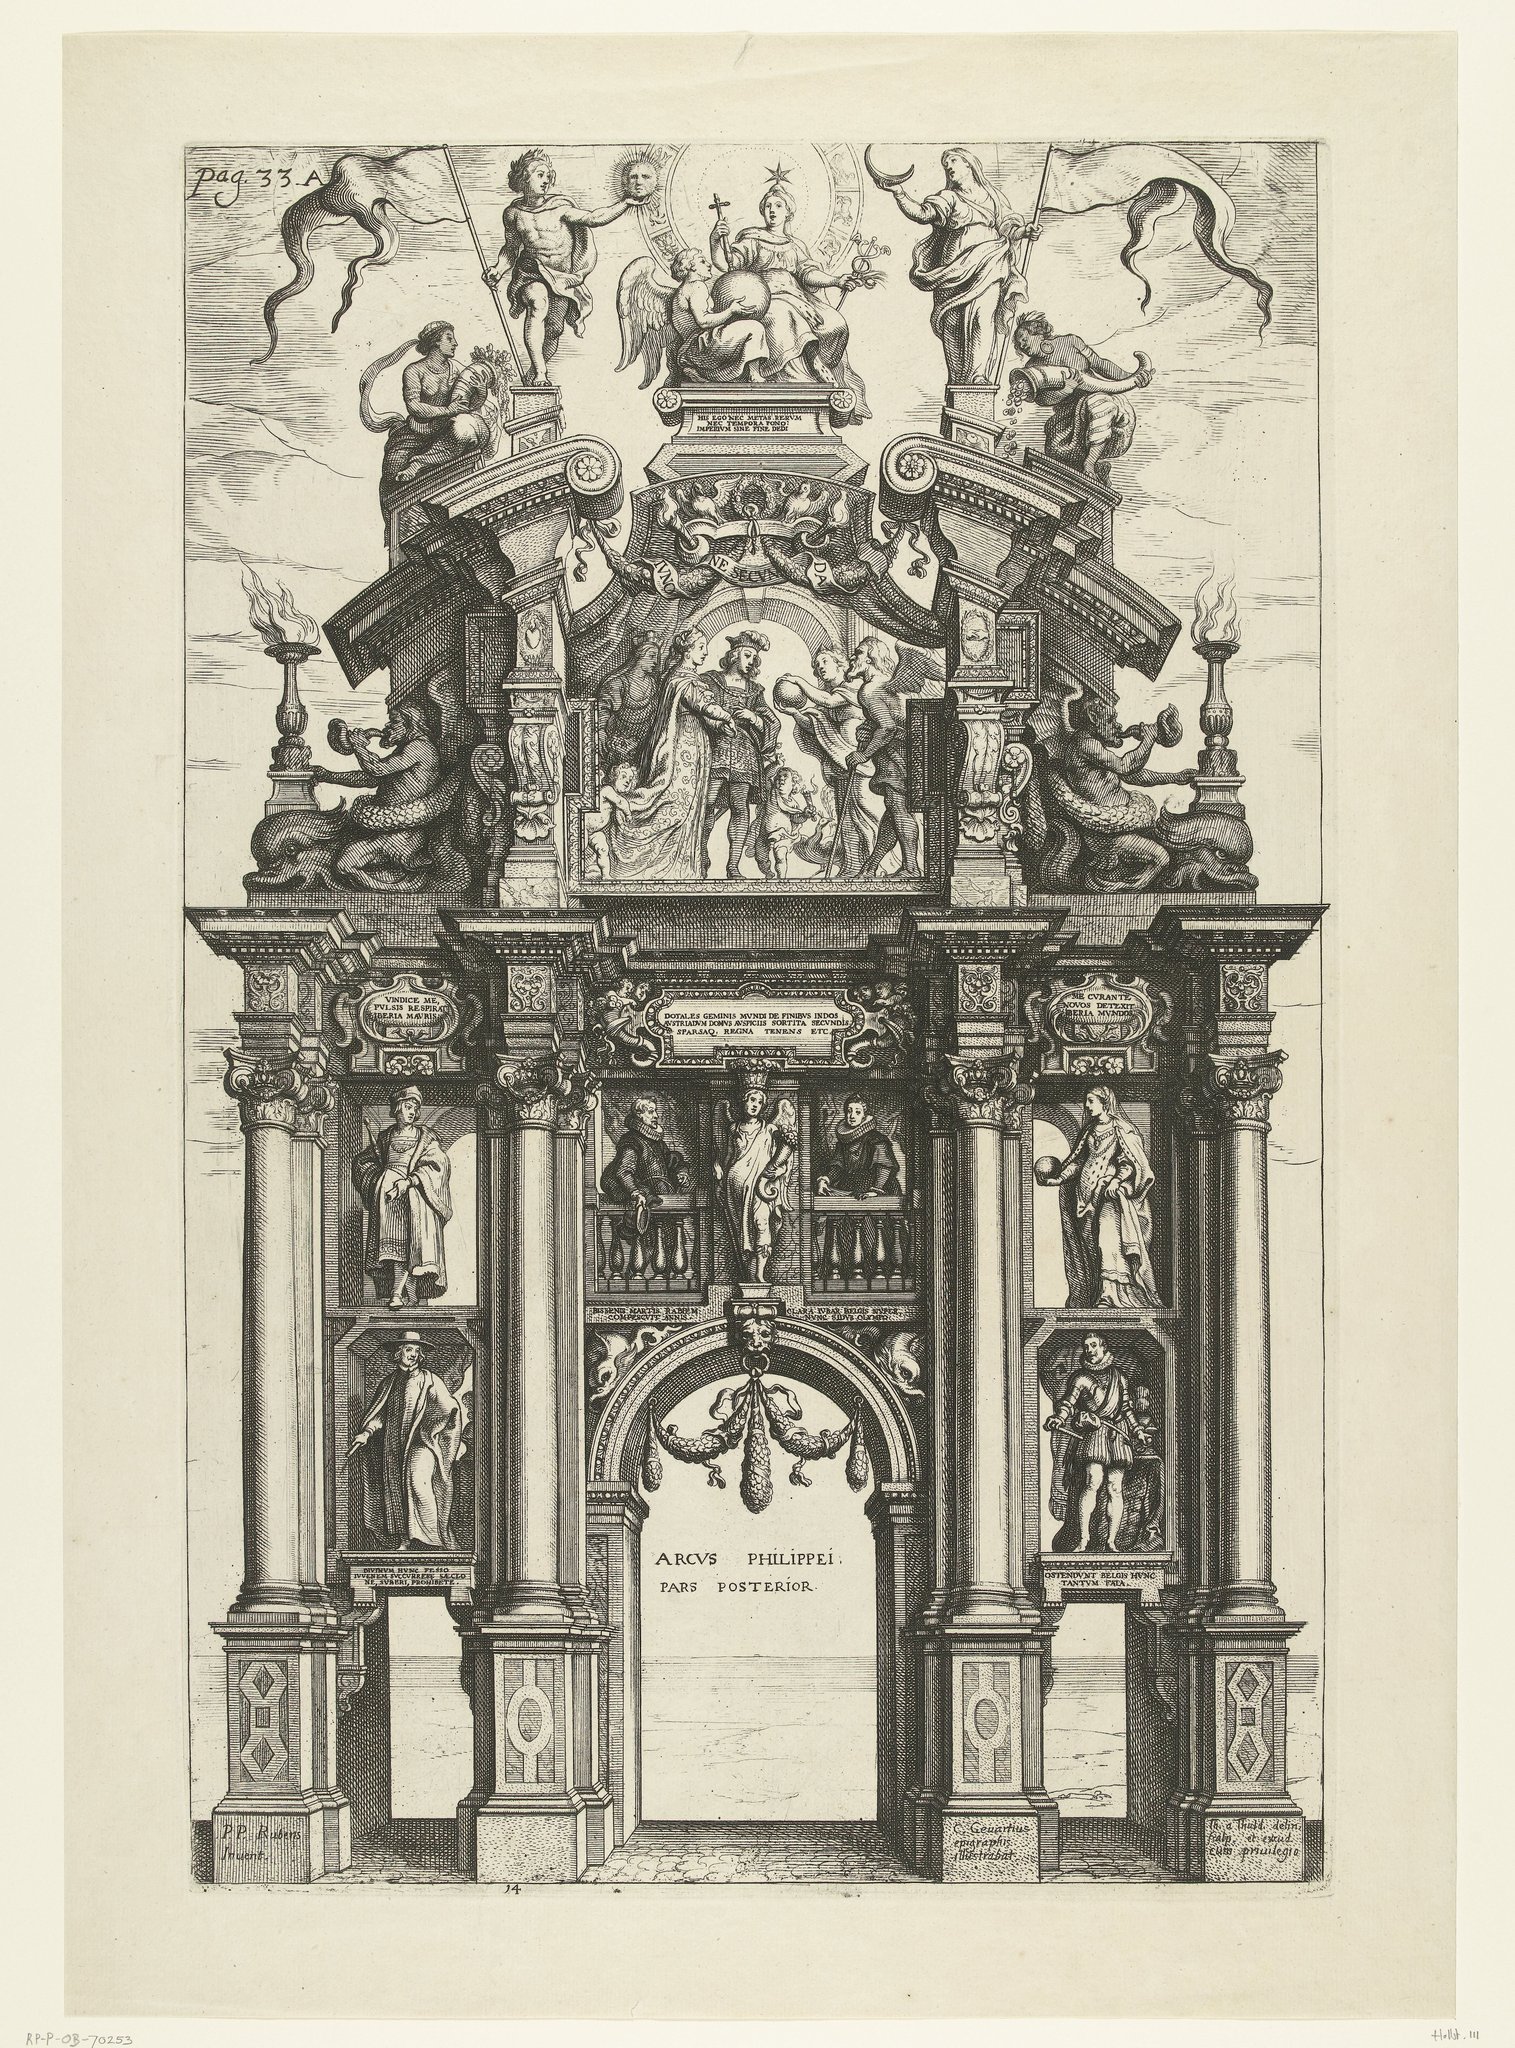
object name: print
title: Arcus Philippei Pars posterior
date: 1639-1641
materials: paper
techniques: engraving, etching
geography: southern netherlands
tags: bruges, filips de schone (hertog van bourgondië), brussels, landvoogd der zuidelijke nederlanden ferdinand van oostenrijk, triumphal arch, antwerp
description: De triomfboog van Filips op de hoek van de Huidevetterstraat en de Meir (achterzijde). In de centrale voorstelling het huwelijk tussen Filips de Schone en Johanna van Castilië in 1496. Bovenaan de personificatie van de Habsburgse monarchie omgeven door de tekens van de dierenriem. Gemerkt linksboven: pag. 33A. Blad nr. 14 in een geheel van 43 platen die de uitgave van de beschrijving van de intocht van de Kardinaal Infant Ferdinand van Oostenrijk te Antwerpen op 17 april 1635 als de nieuwe landvoogd voor de Spaanse Nederlanden illustreren.